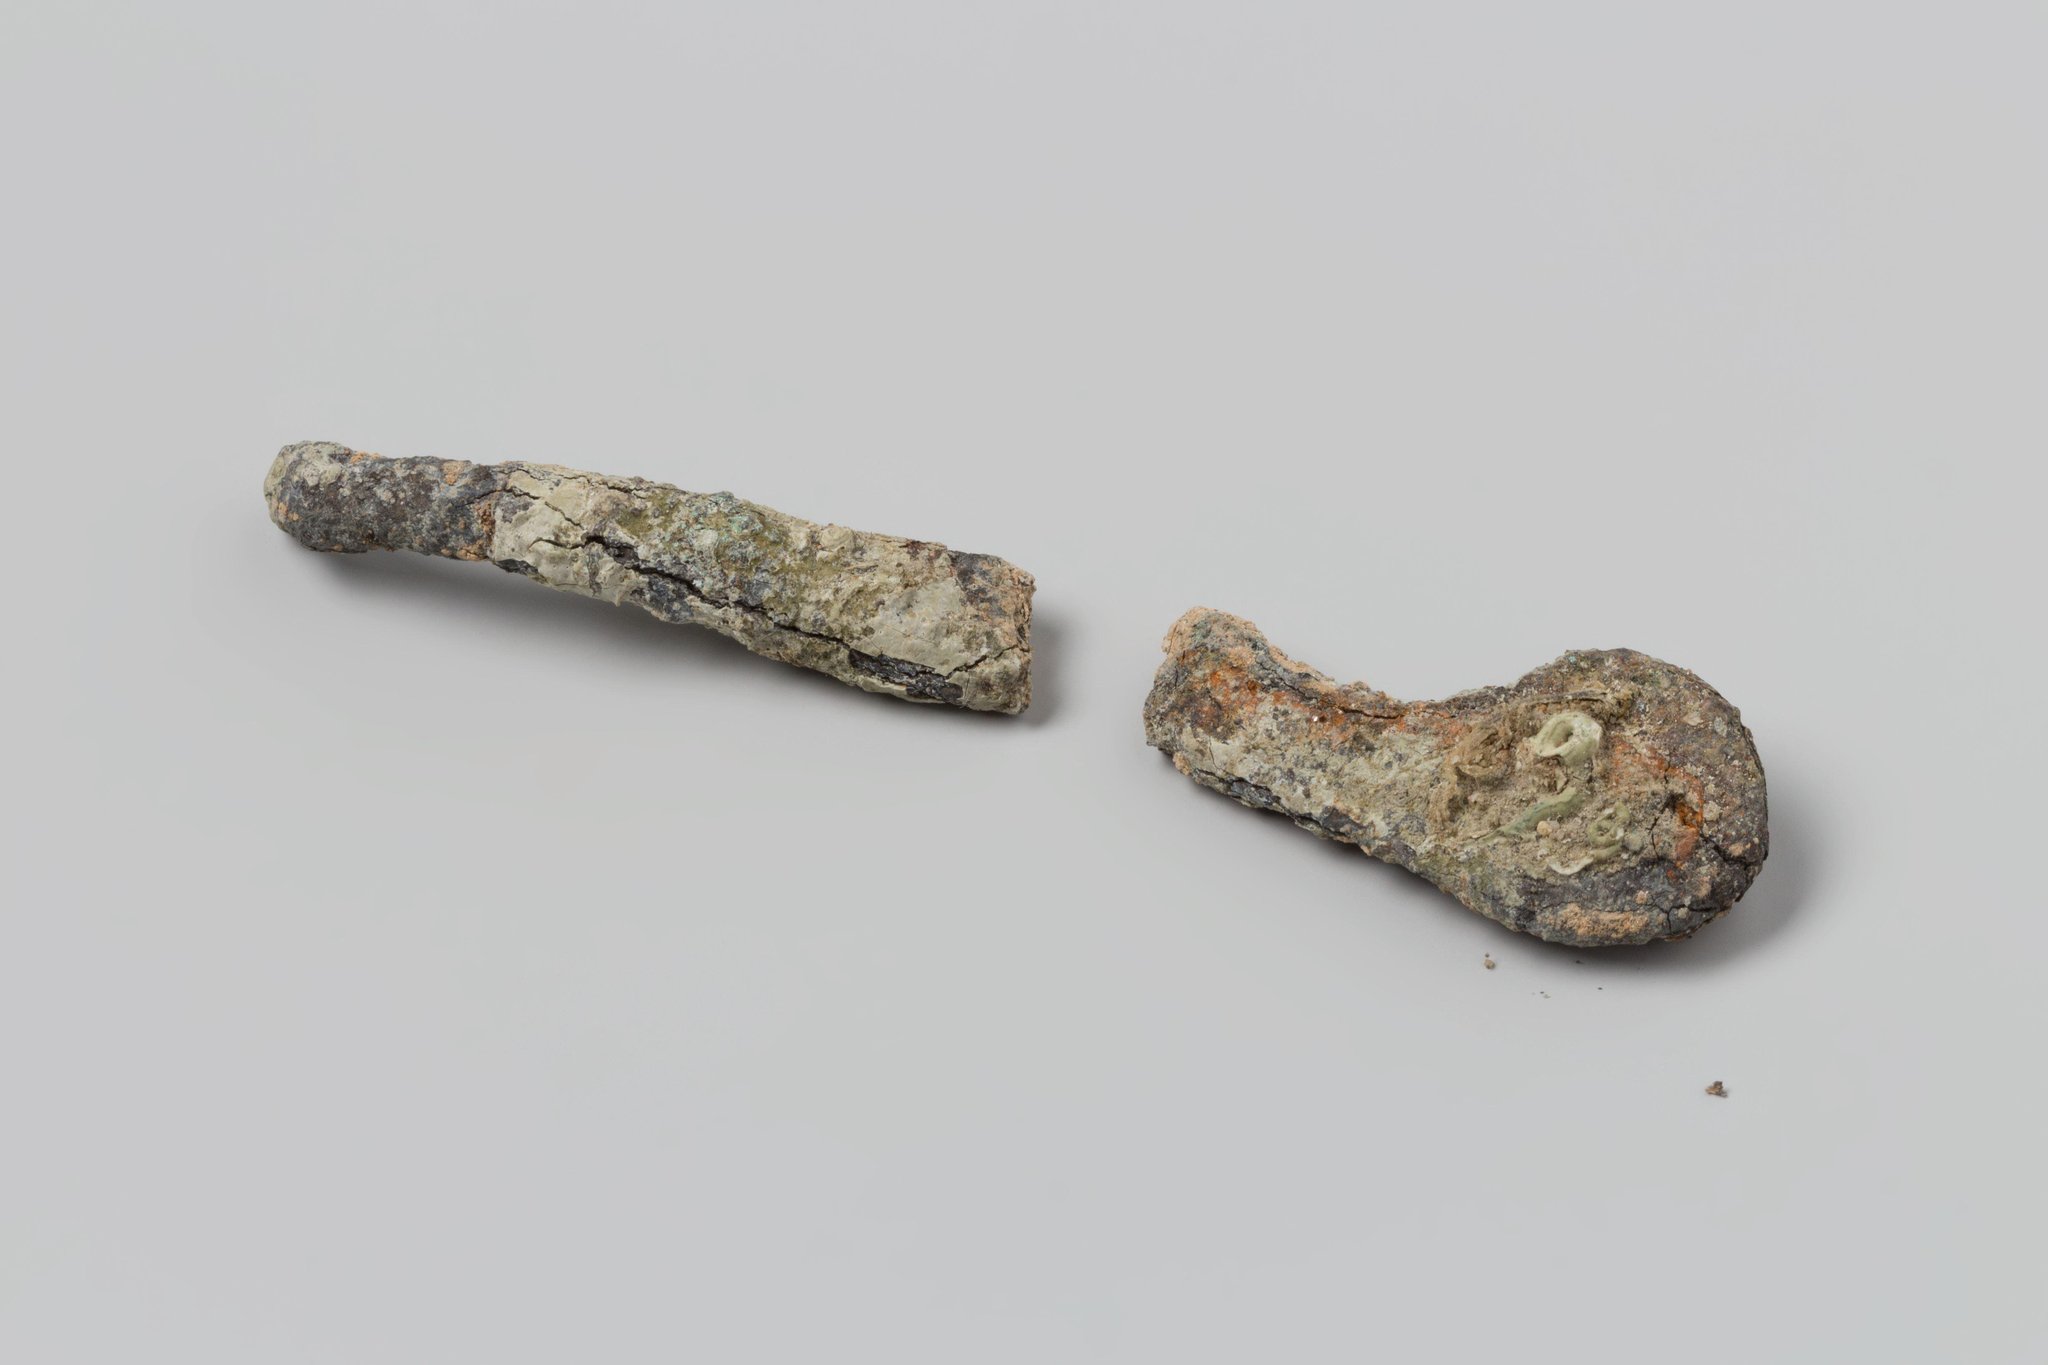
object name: fork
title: Fragmenten steel van vork of lepel uit het wrak van de Oost-Indiëvaarder Hollandia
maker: Anonymous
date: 1700-1743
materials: tin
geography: netherlands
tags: verenigde oostindische compagnie, hollandia (schip), annet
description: Cutlery, fragment: stem of fork or spoon; fragm, id. NG 1980-27H67.